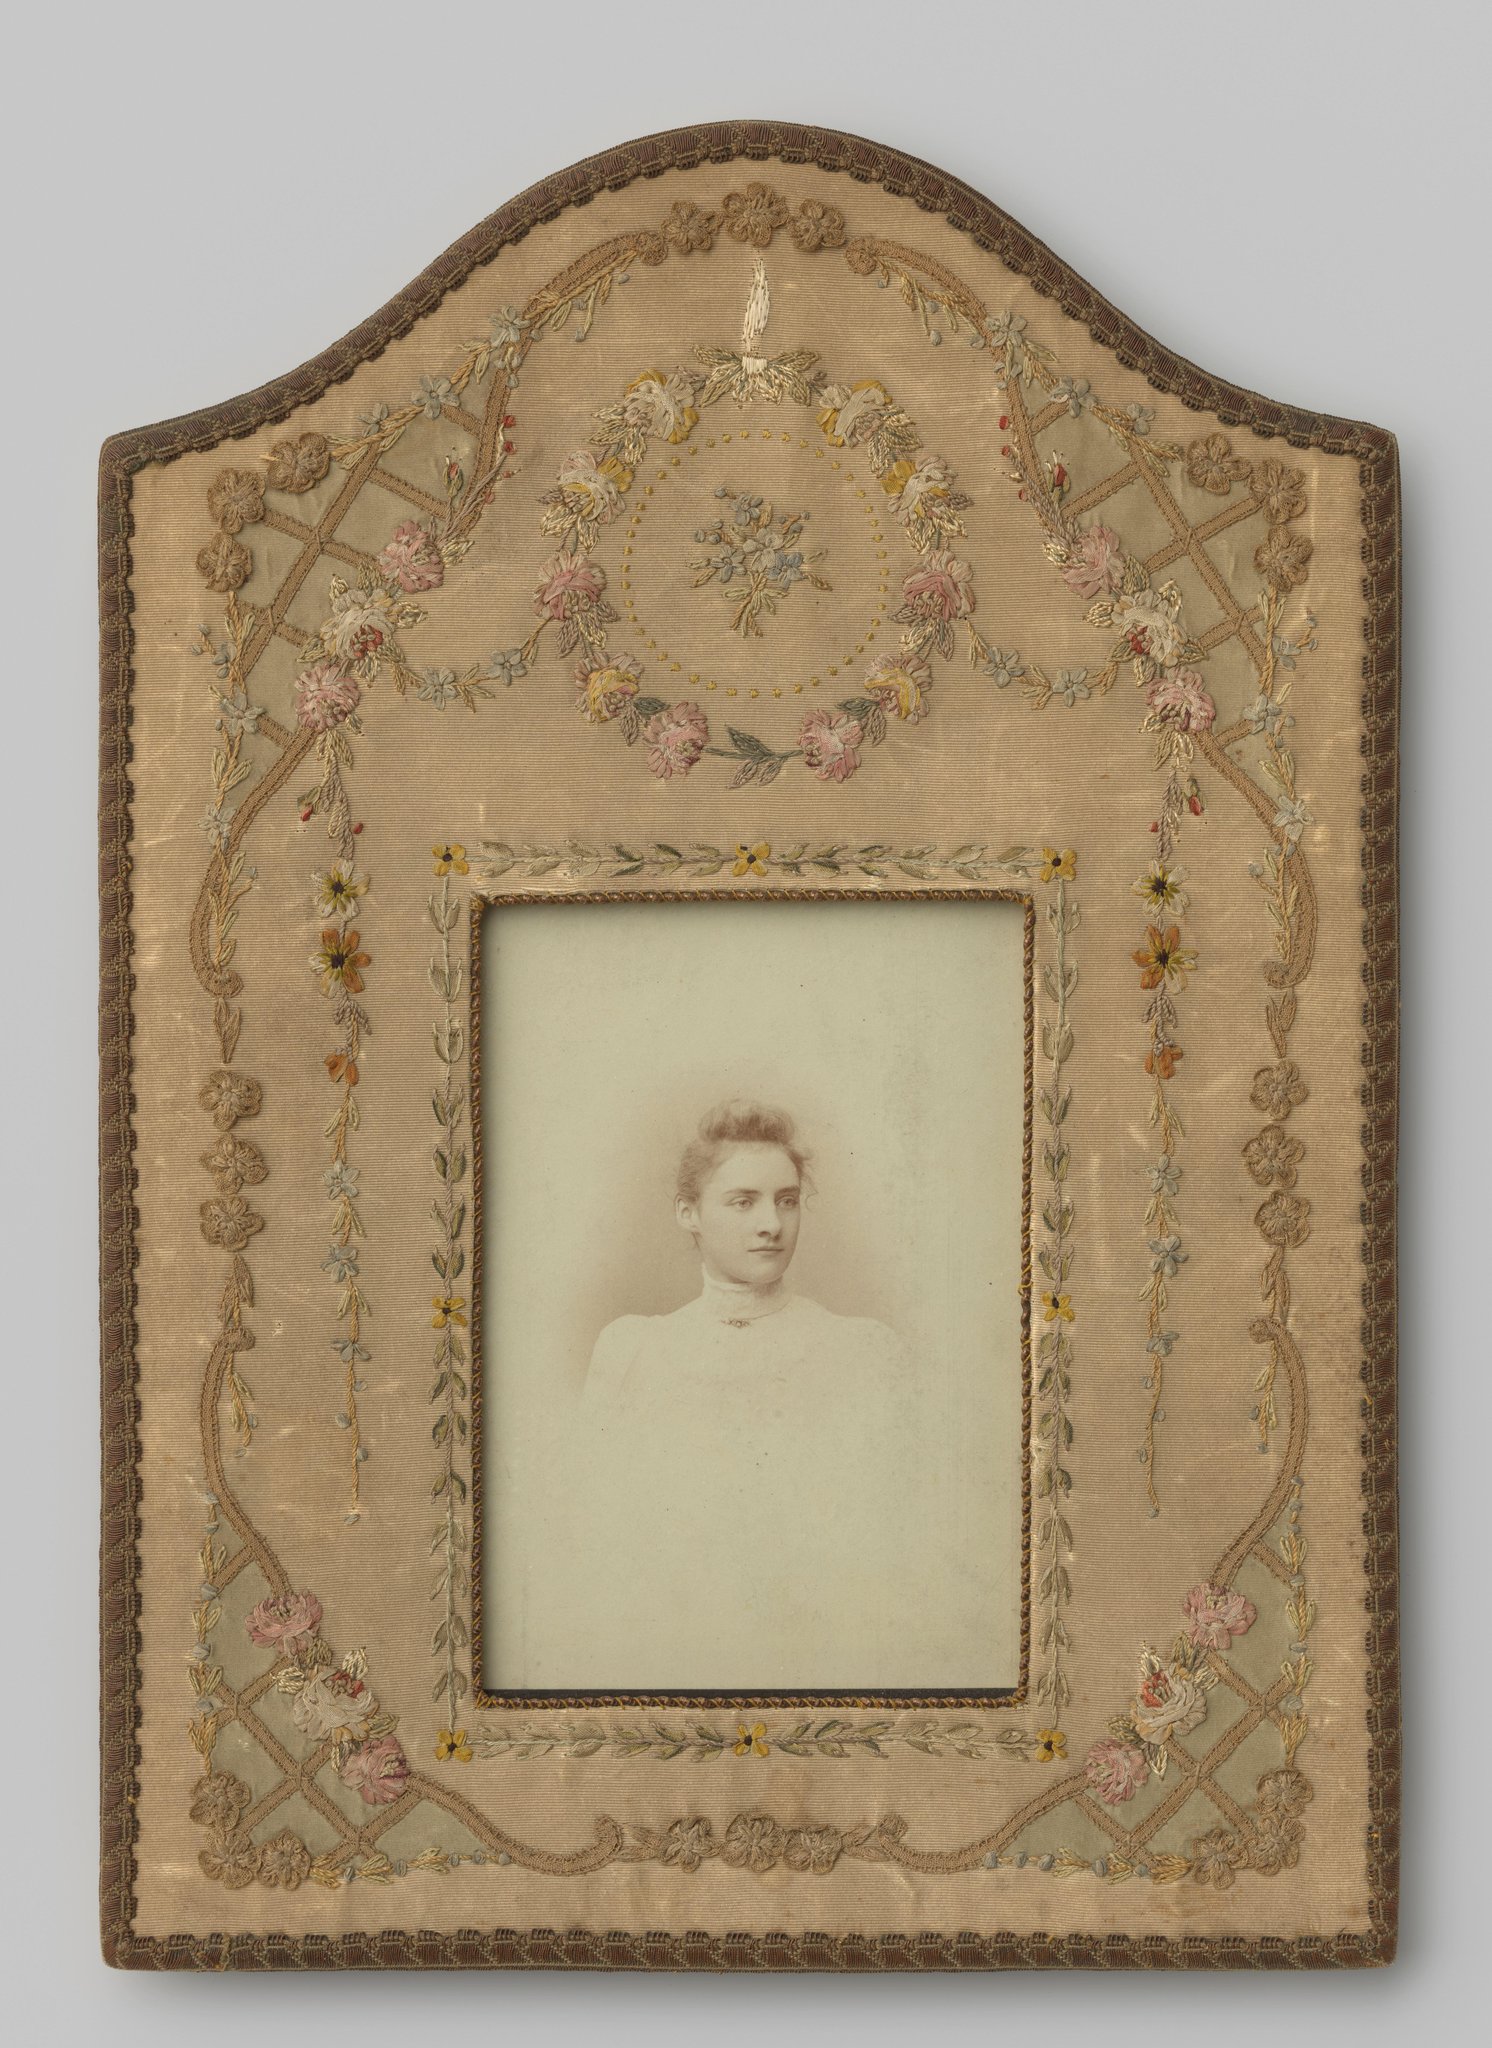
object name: photograph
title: Portret van een onbekende jonge vrouw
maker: Anonymous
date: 1880-1900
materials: cardboard, glass, metal, paper, textile, wood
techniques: albumen print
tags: adolescent, young woman, maiden, anonymous historical person portrayed